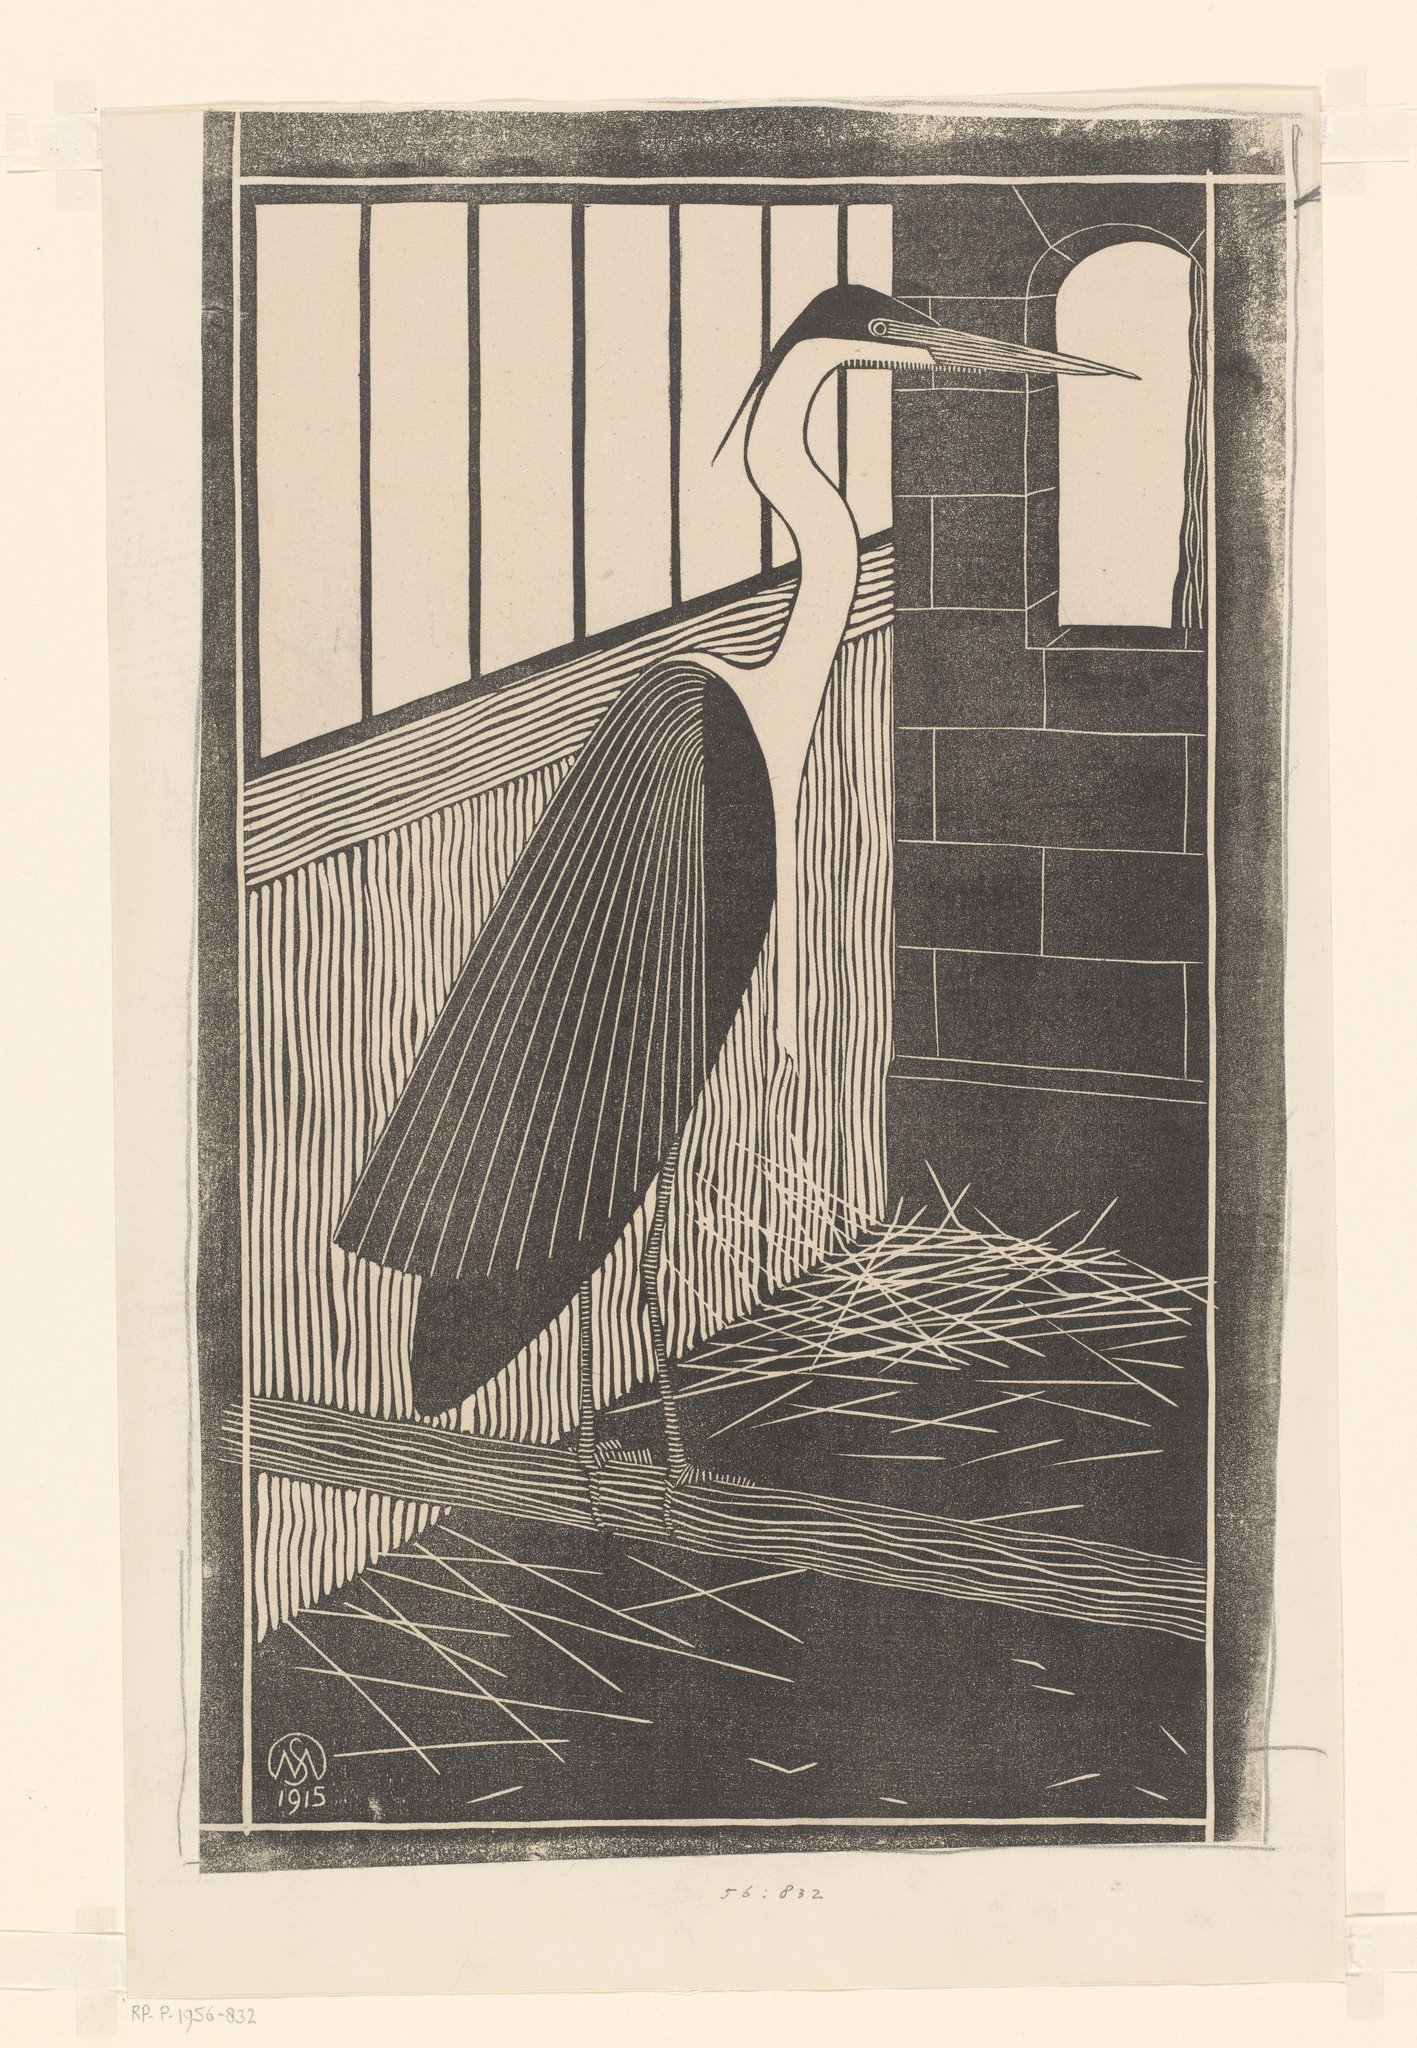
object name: print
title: Reuzenreiger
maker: samuel jessurun de mesquita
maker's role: draughtsman, print maker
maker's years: 1868-1944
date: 1915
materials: paper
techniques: woodcut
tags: shore-birds and wading-birds: heron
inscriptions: signature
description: De reiger staat op een balk in een hok met stro op de vloer.